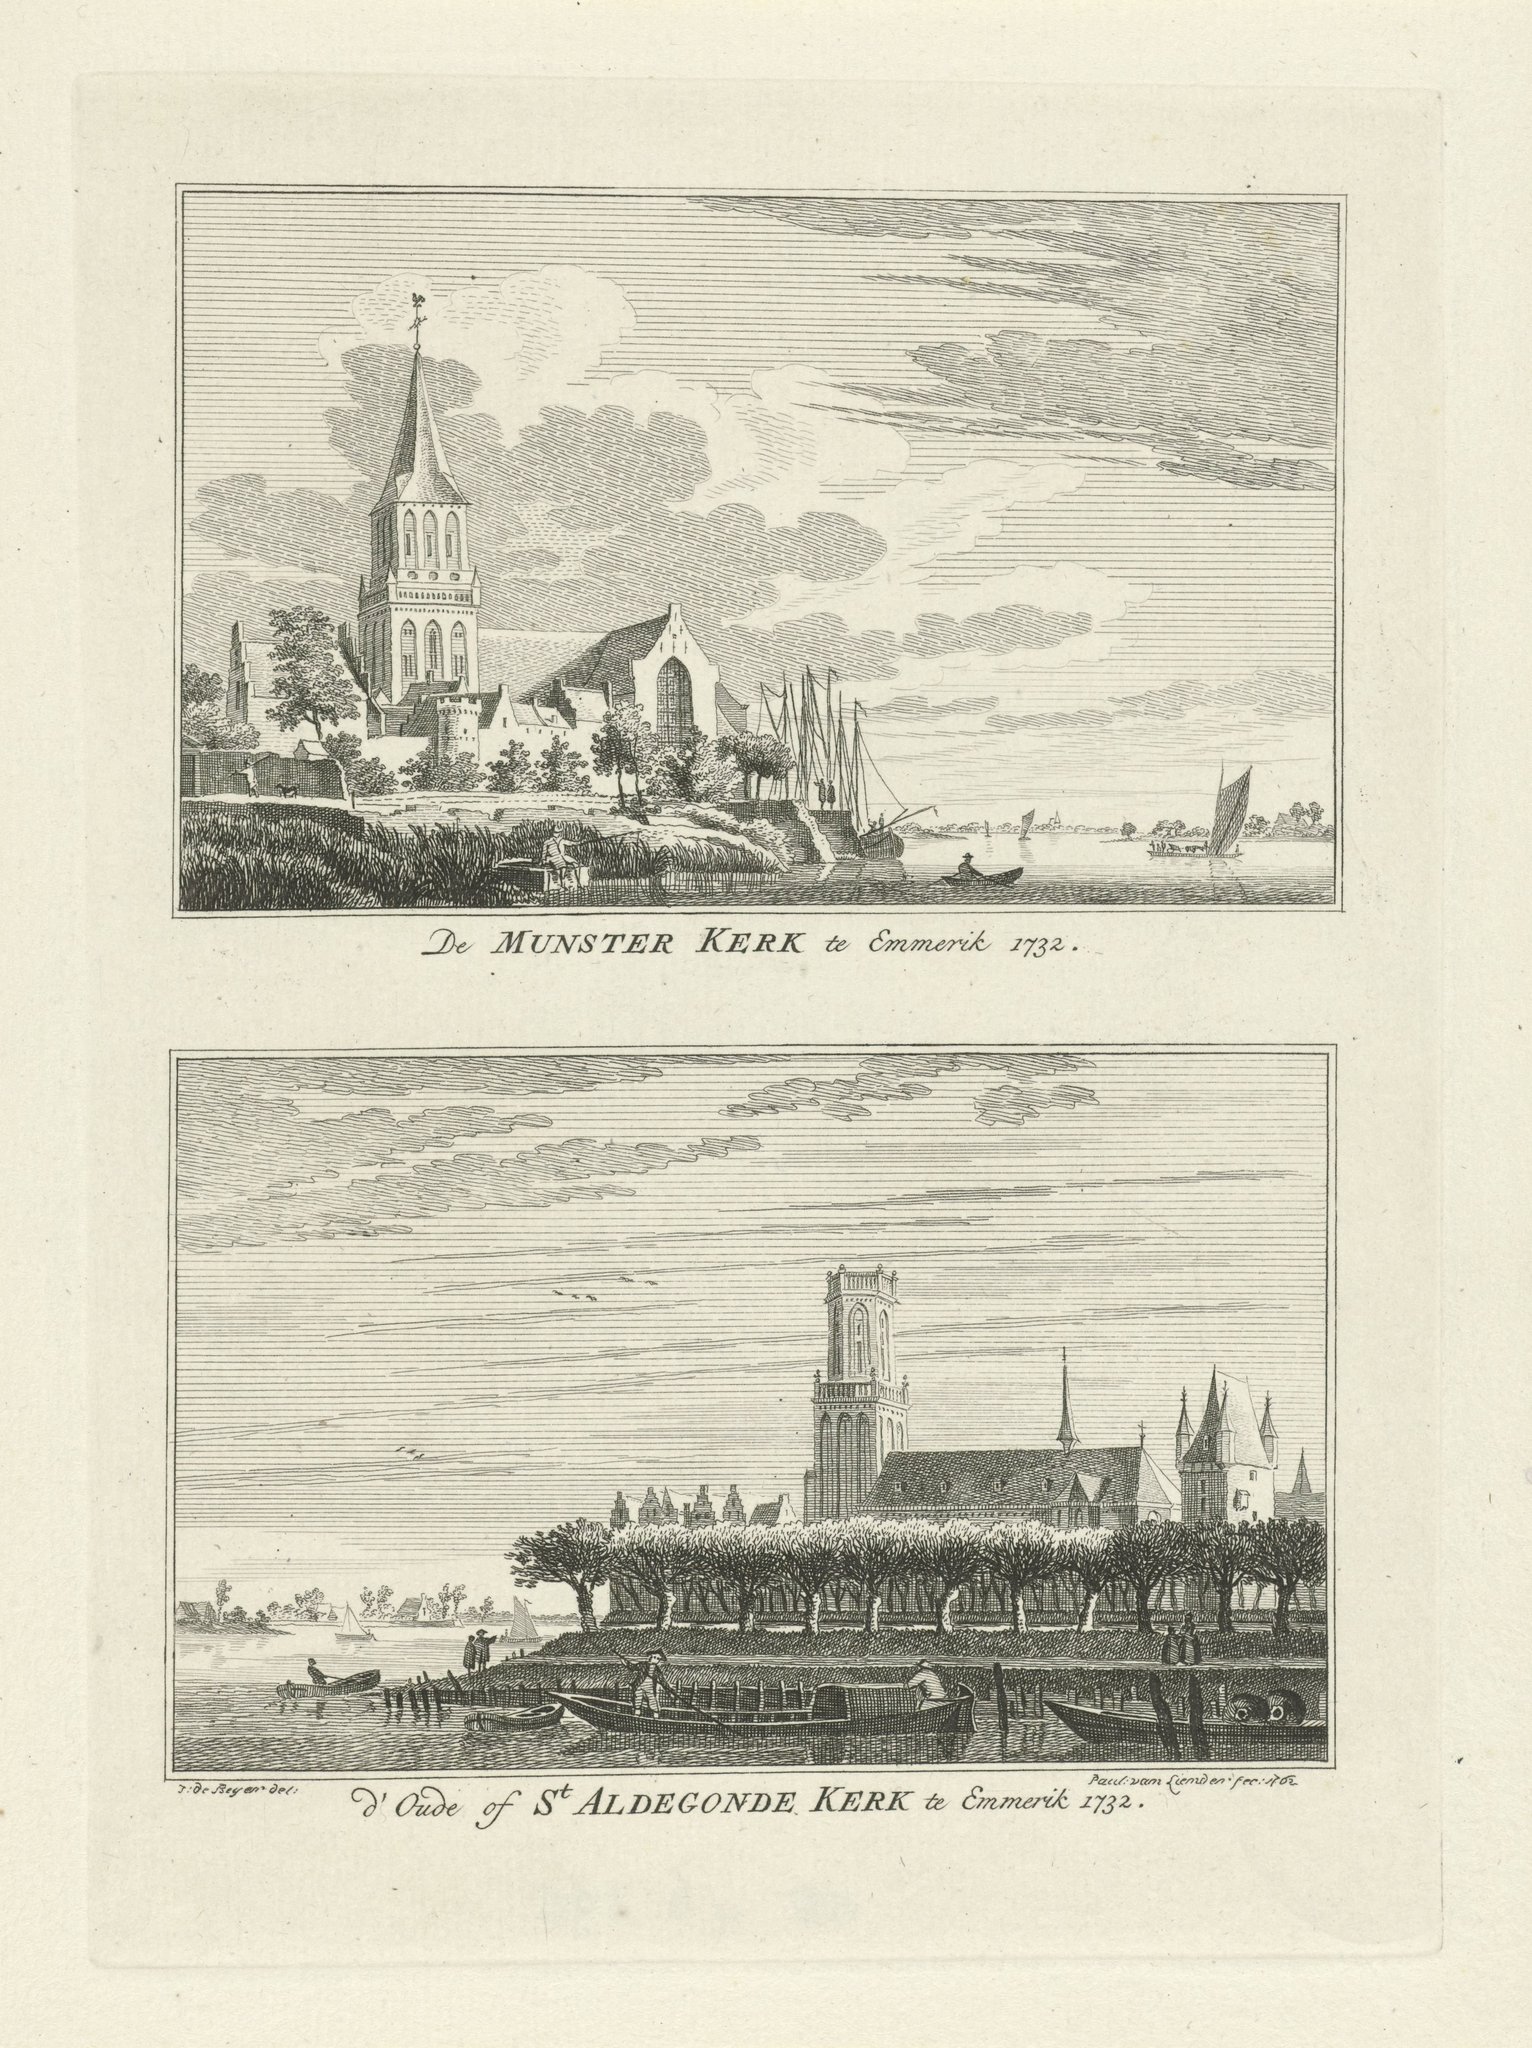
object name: print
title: De Munster Kerk te Emmerik / d'Oude of St Aldegonde Kerk te Emmerik 1732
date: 1762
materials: paper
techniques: etching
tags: landscapes with waters, waterscapes, seascapes (in the temperate zone), church (exterior)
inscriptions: collector's mark: Lugt 240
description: Twee voorstellingen van één plaat. Gezichten op de Munsterkerk (boven) en de Sint-Aldegondekerk (onder) aan de Rijn te Emmerik, Duitsland. De prent maakt deel uit van een 100-delige serie met gezichten op dorpen en steden te Kleef.